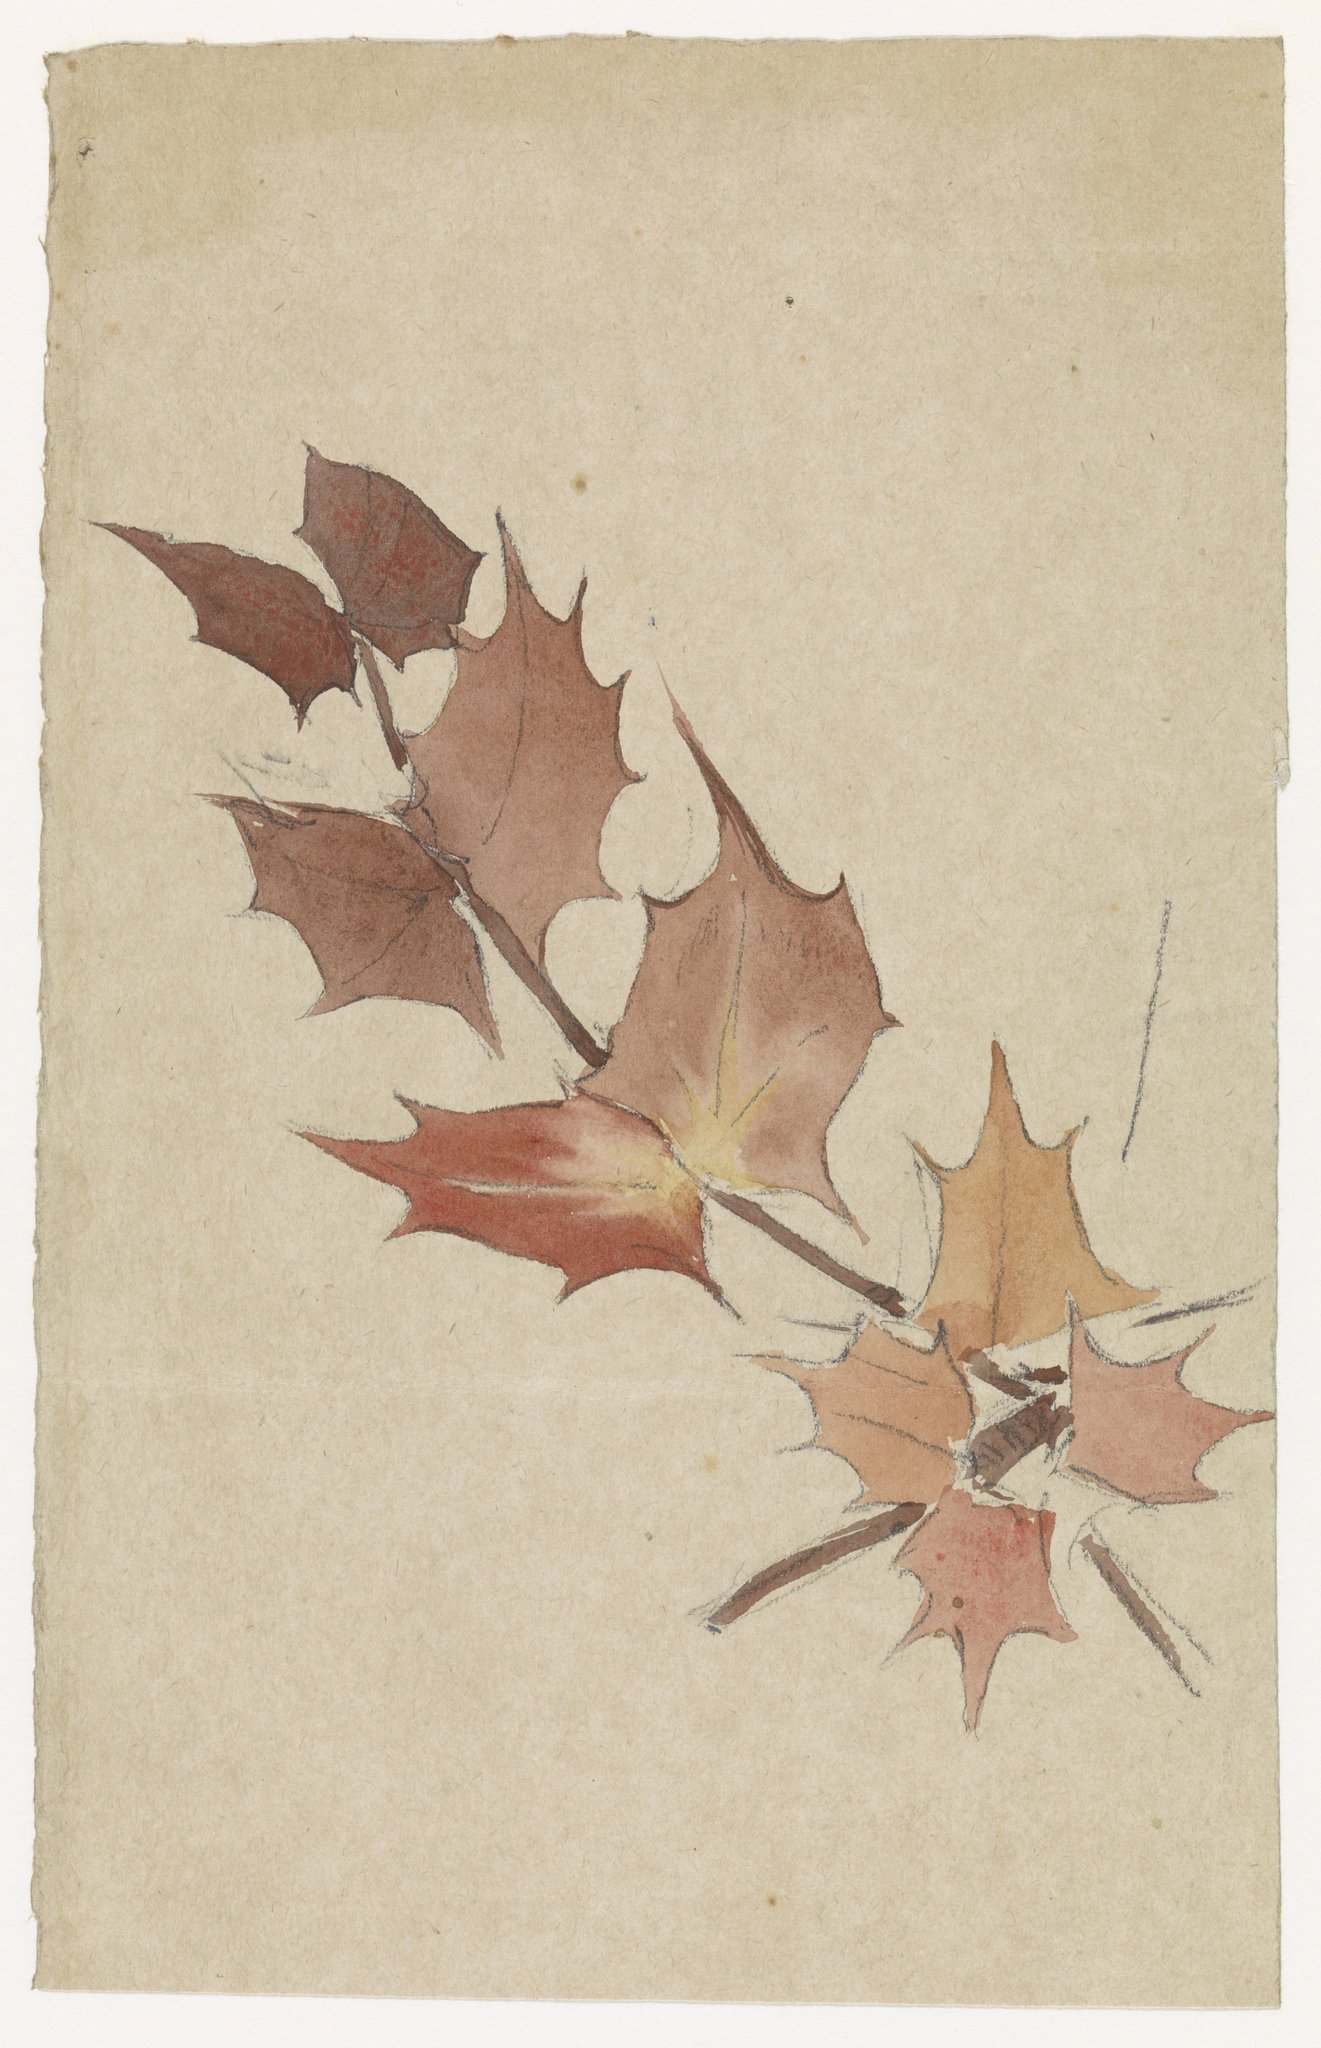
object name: drawing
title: Takje hulst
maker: antoon derkinderen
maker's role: draughtsman, painter, print maker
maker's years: 1859-1925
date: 1869-1925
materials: paper, pencil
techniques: brush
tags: plants and herbs: holly